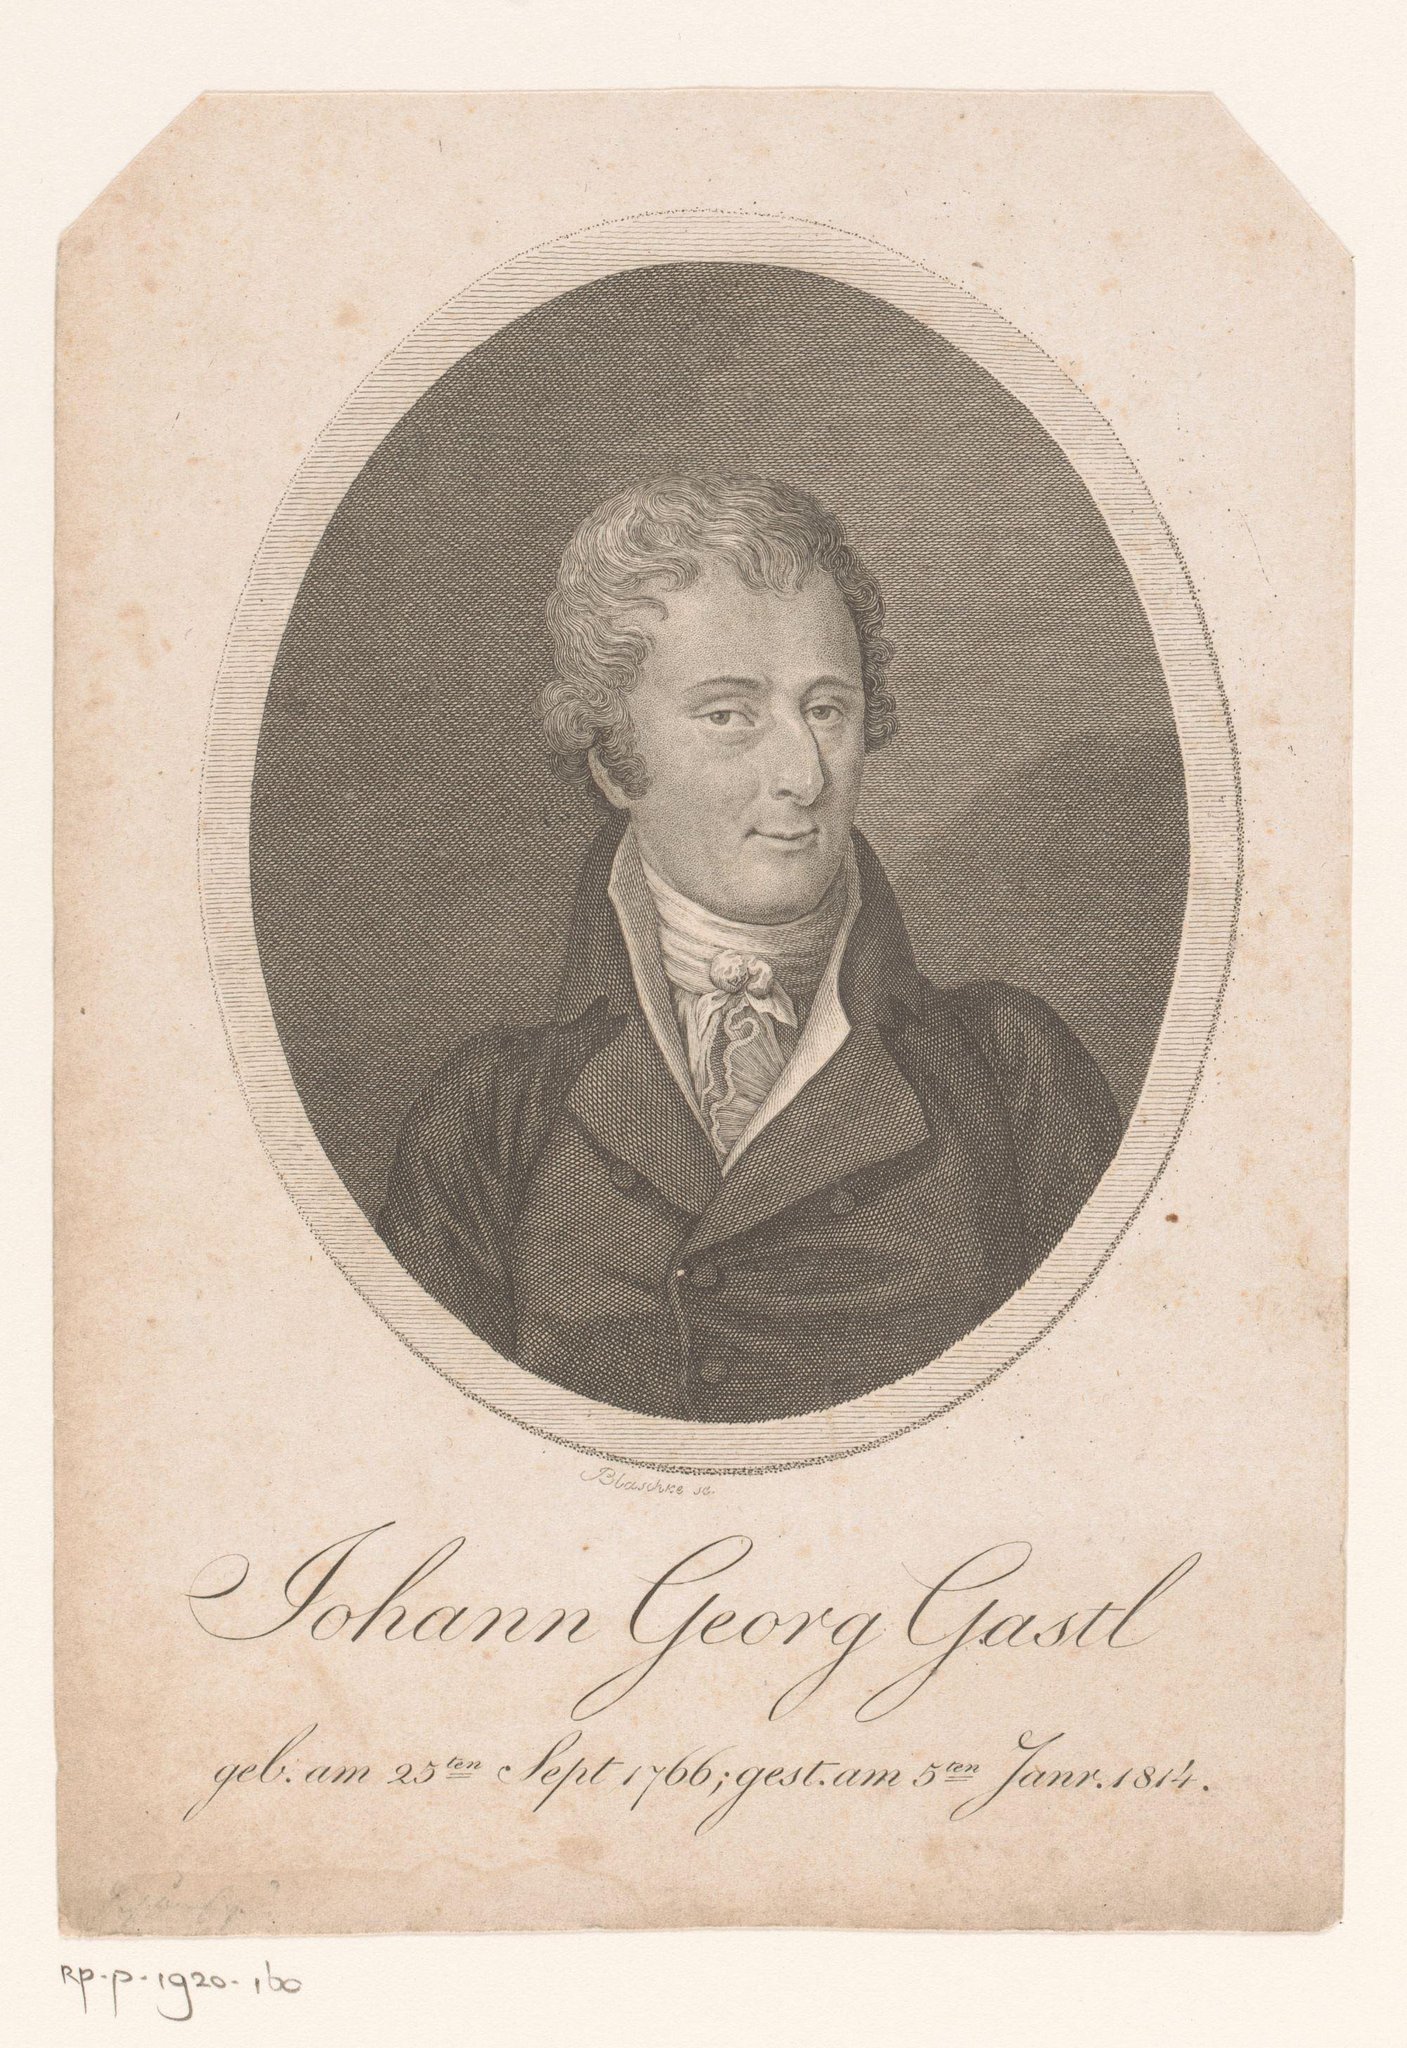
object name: print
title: Portret van Johann Georg Gastl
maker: jános blaschke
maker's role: print maker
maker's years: 1770-1833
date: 1780-1833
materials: paper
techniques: engraving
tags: historical persons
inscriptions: collector's mark: Lugt 2228